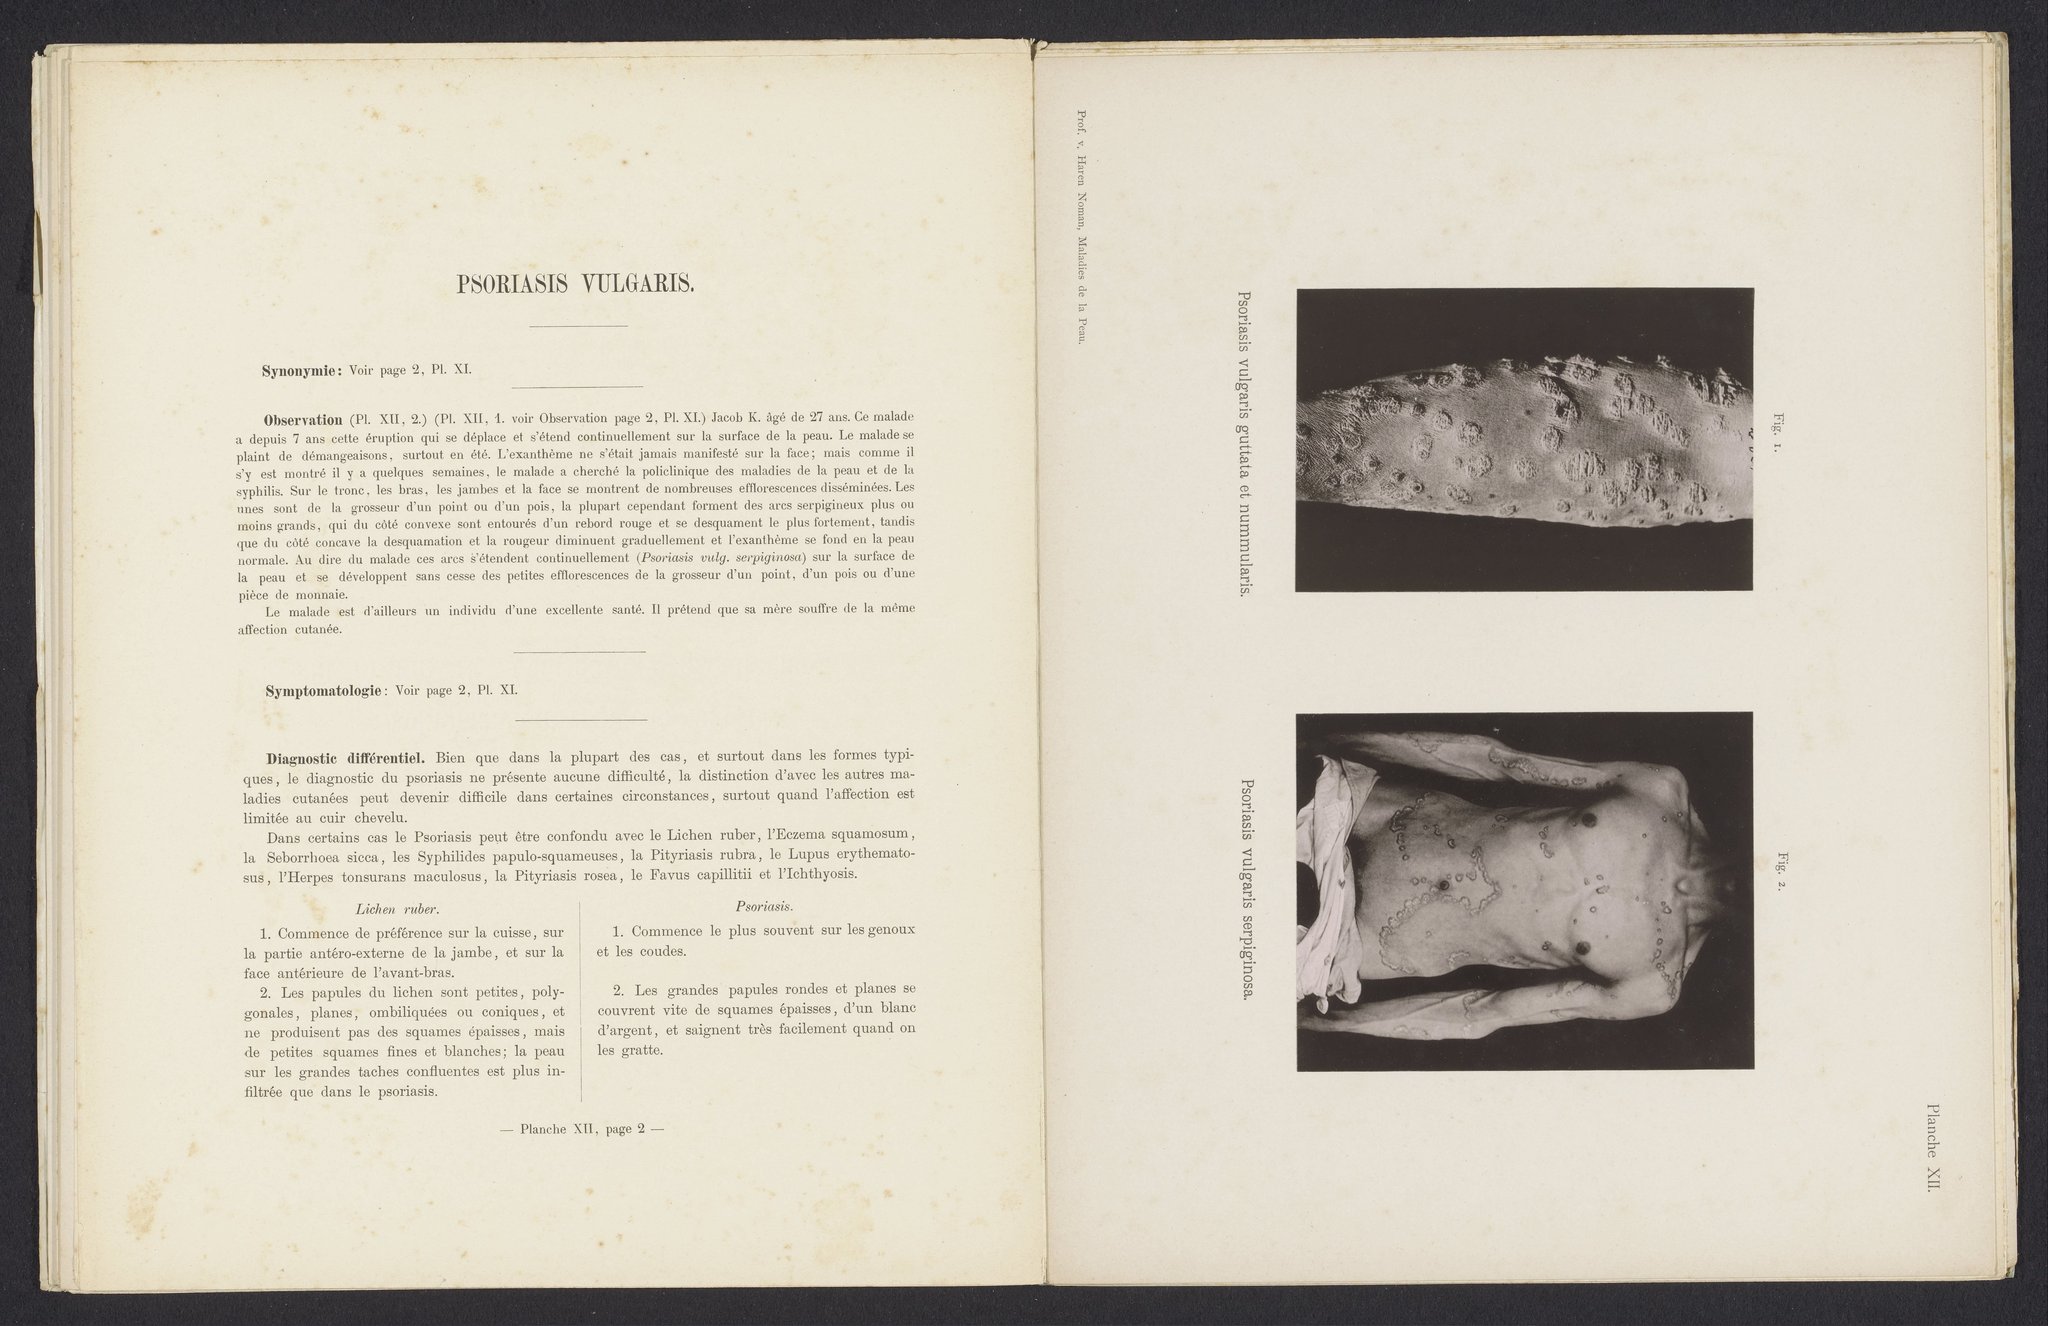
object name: page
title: Patiënten lijdend aan de huidziekte 'psoriasis vulgaris guttata et nummularis' en 'psoriasis vulgaris serpiginosa'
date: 1880-1889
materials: paper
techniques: photograph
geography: amsterdam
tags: chest, bust, skin and venereal diseases, adult man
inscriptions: number: ‘Planche XII. / Fig. 1. / Fig. 2.’